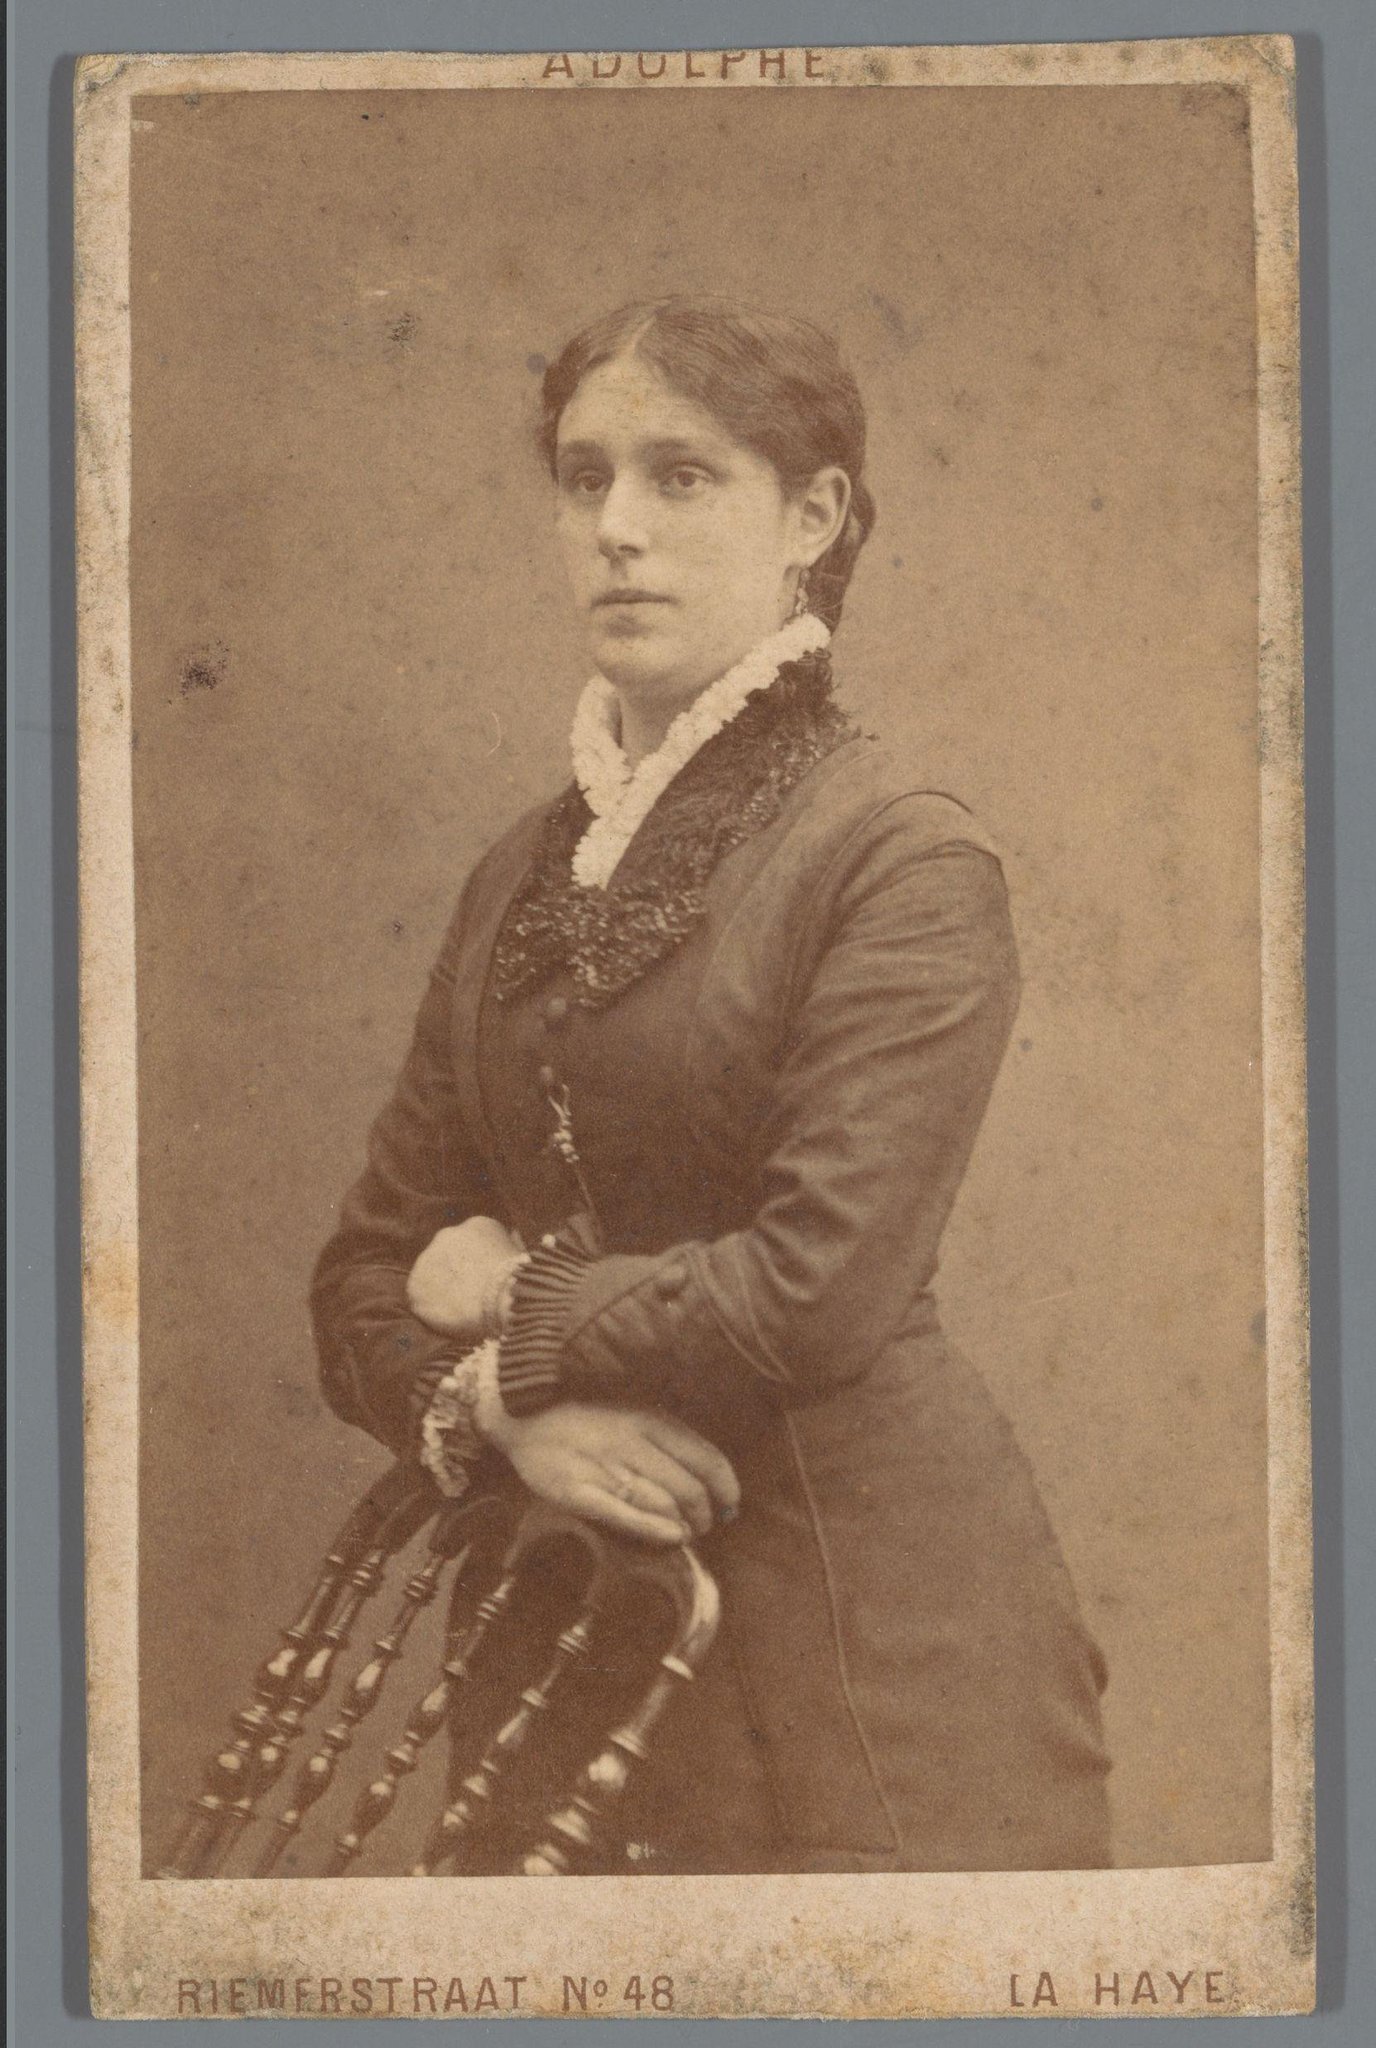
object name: photograph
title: Portret van een onbekende vrouw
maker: adolphe zimmermans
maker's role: fotograaf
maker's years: 1858-1922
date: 1879-1883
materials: cardboard, paper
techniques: albumen print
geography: the hague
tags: adult woman, anonymous historical person portrayed, the hague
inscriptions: inscription: ‘Adolphe/ Riemerstraat No.48 La Haye’, inscription: ‘Adolphe Zimmermans/ Photographe/ Riemerstraat No.48/ La Haye’